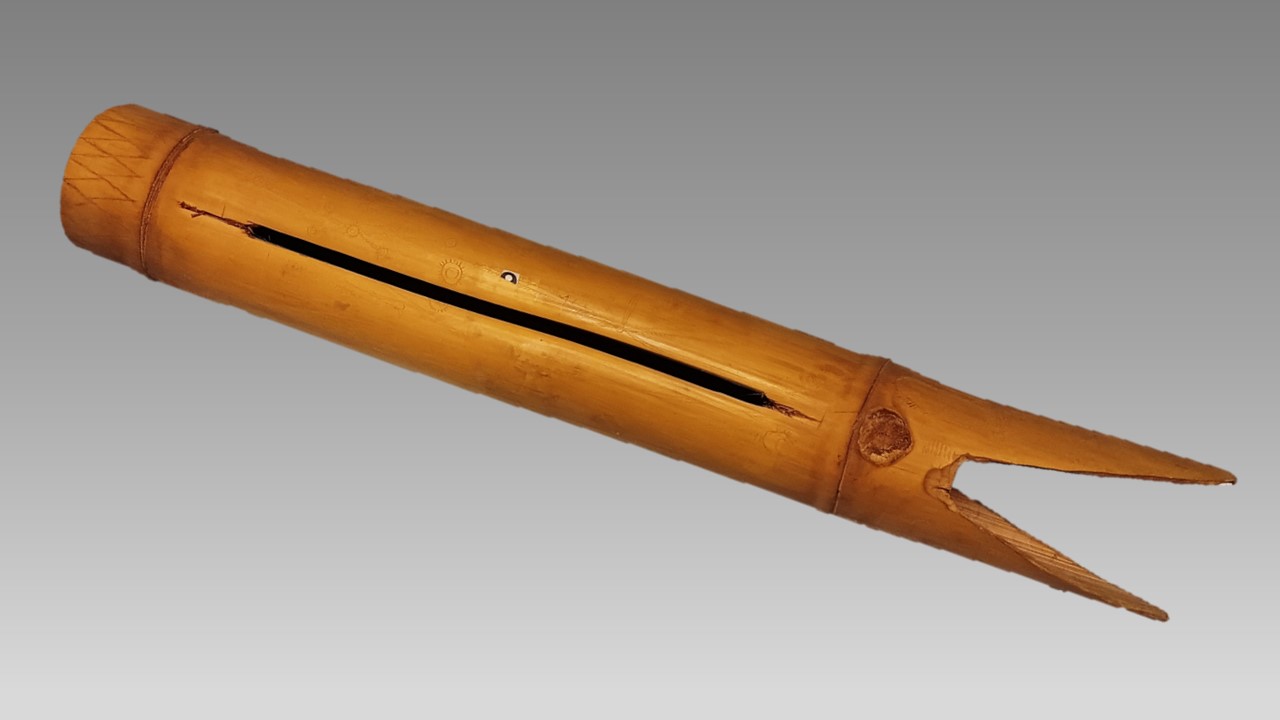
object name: kove slit drum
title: Kove (slit drum)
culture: melanesian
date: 1867-1900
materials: bamboo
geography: vanuatu